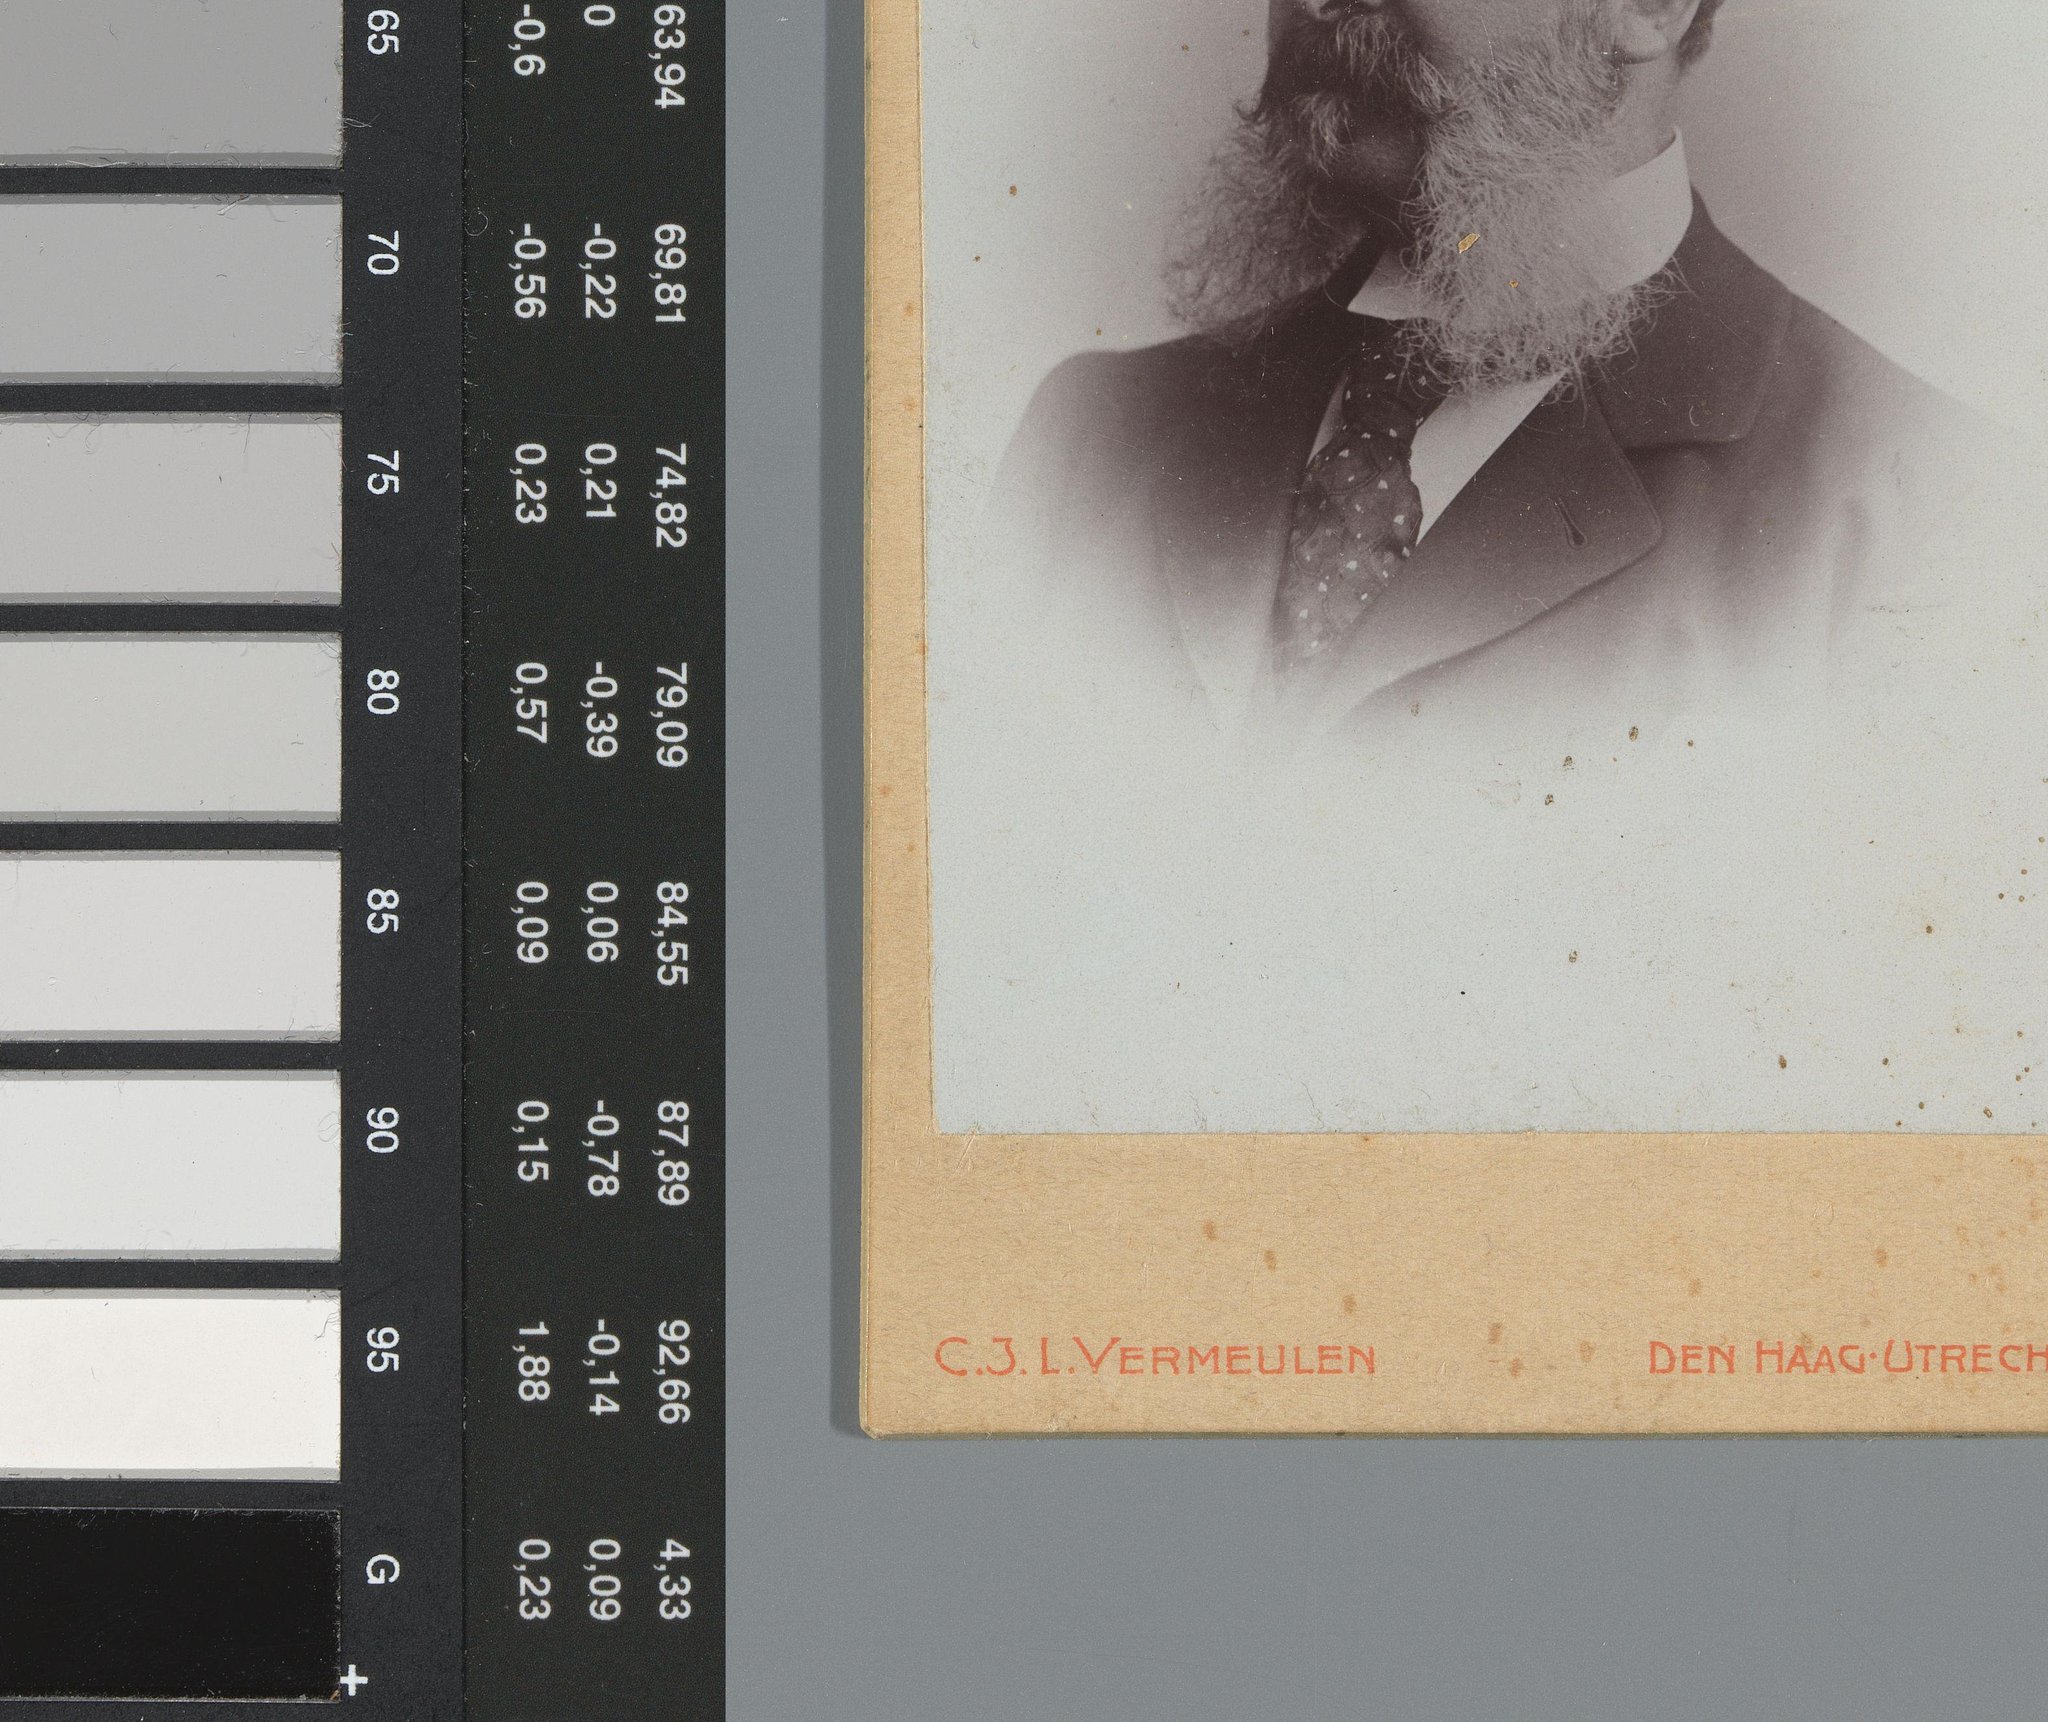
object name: carte de visite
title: Portret van Henri Trip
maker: cornelis johannes lodewicus vermeulen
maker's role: fotograaf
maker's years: 1861-1936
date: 1855-1910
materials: cardboard, photographic support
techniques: albumen print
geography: netherlands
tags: henri trip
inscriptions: name: ‘C.J.L. VERMEULEN / ATELIER VOOR / MODERNE FOTOGRAFIE / DEN HAAG / TOUSSAINTKADE 11 / TELEFOON 1873 / UTRECHT / NIEUWEGRACHT 50 / TELEFOON 750’, name: ‘C.J.L. VERMEULEN DEN HAAG.UTRECHT’, inscription: ‘Oom Trip’